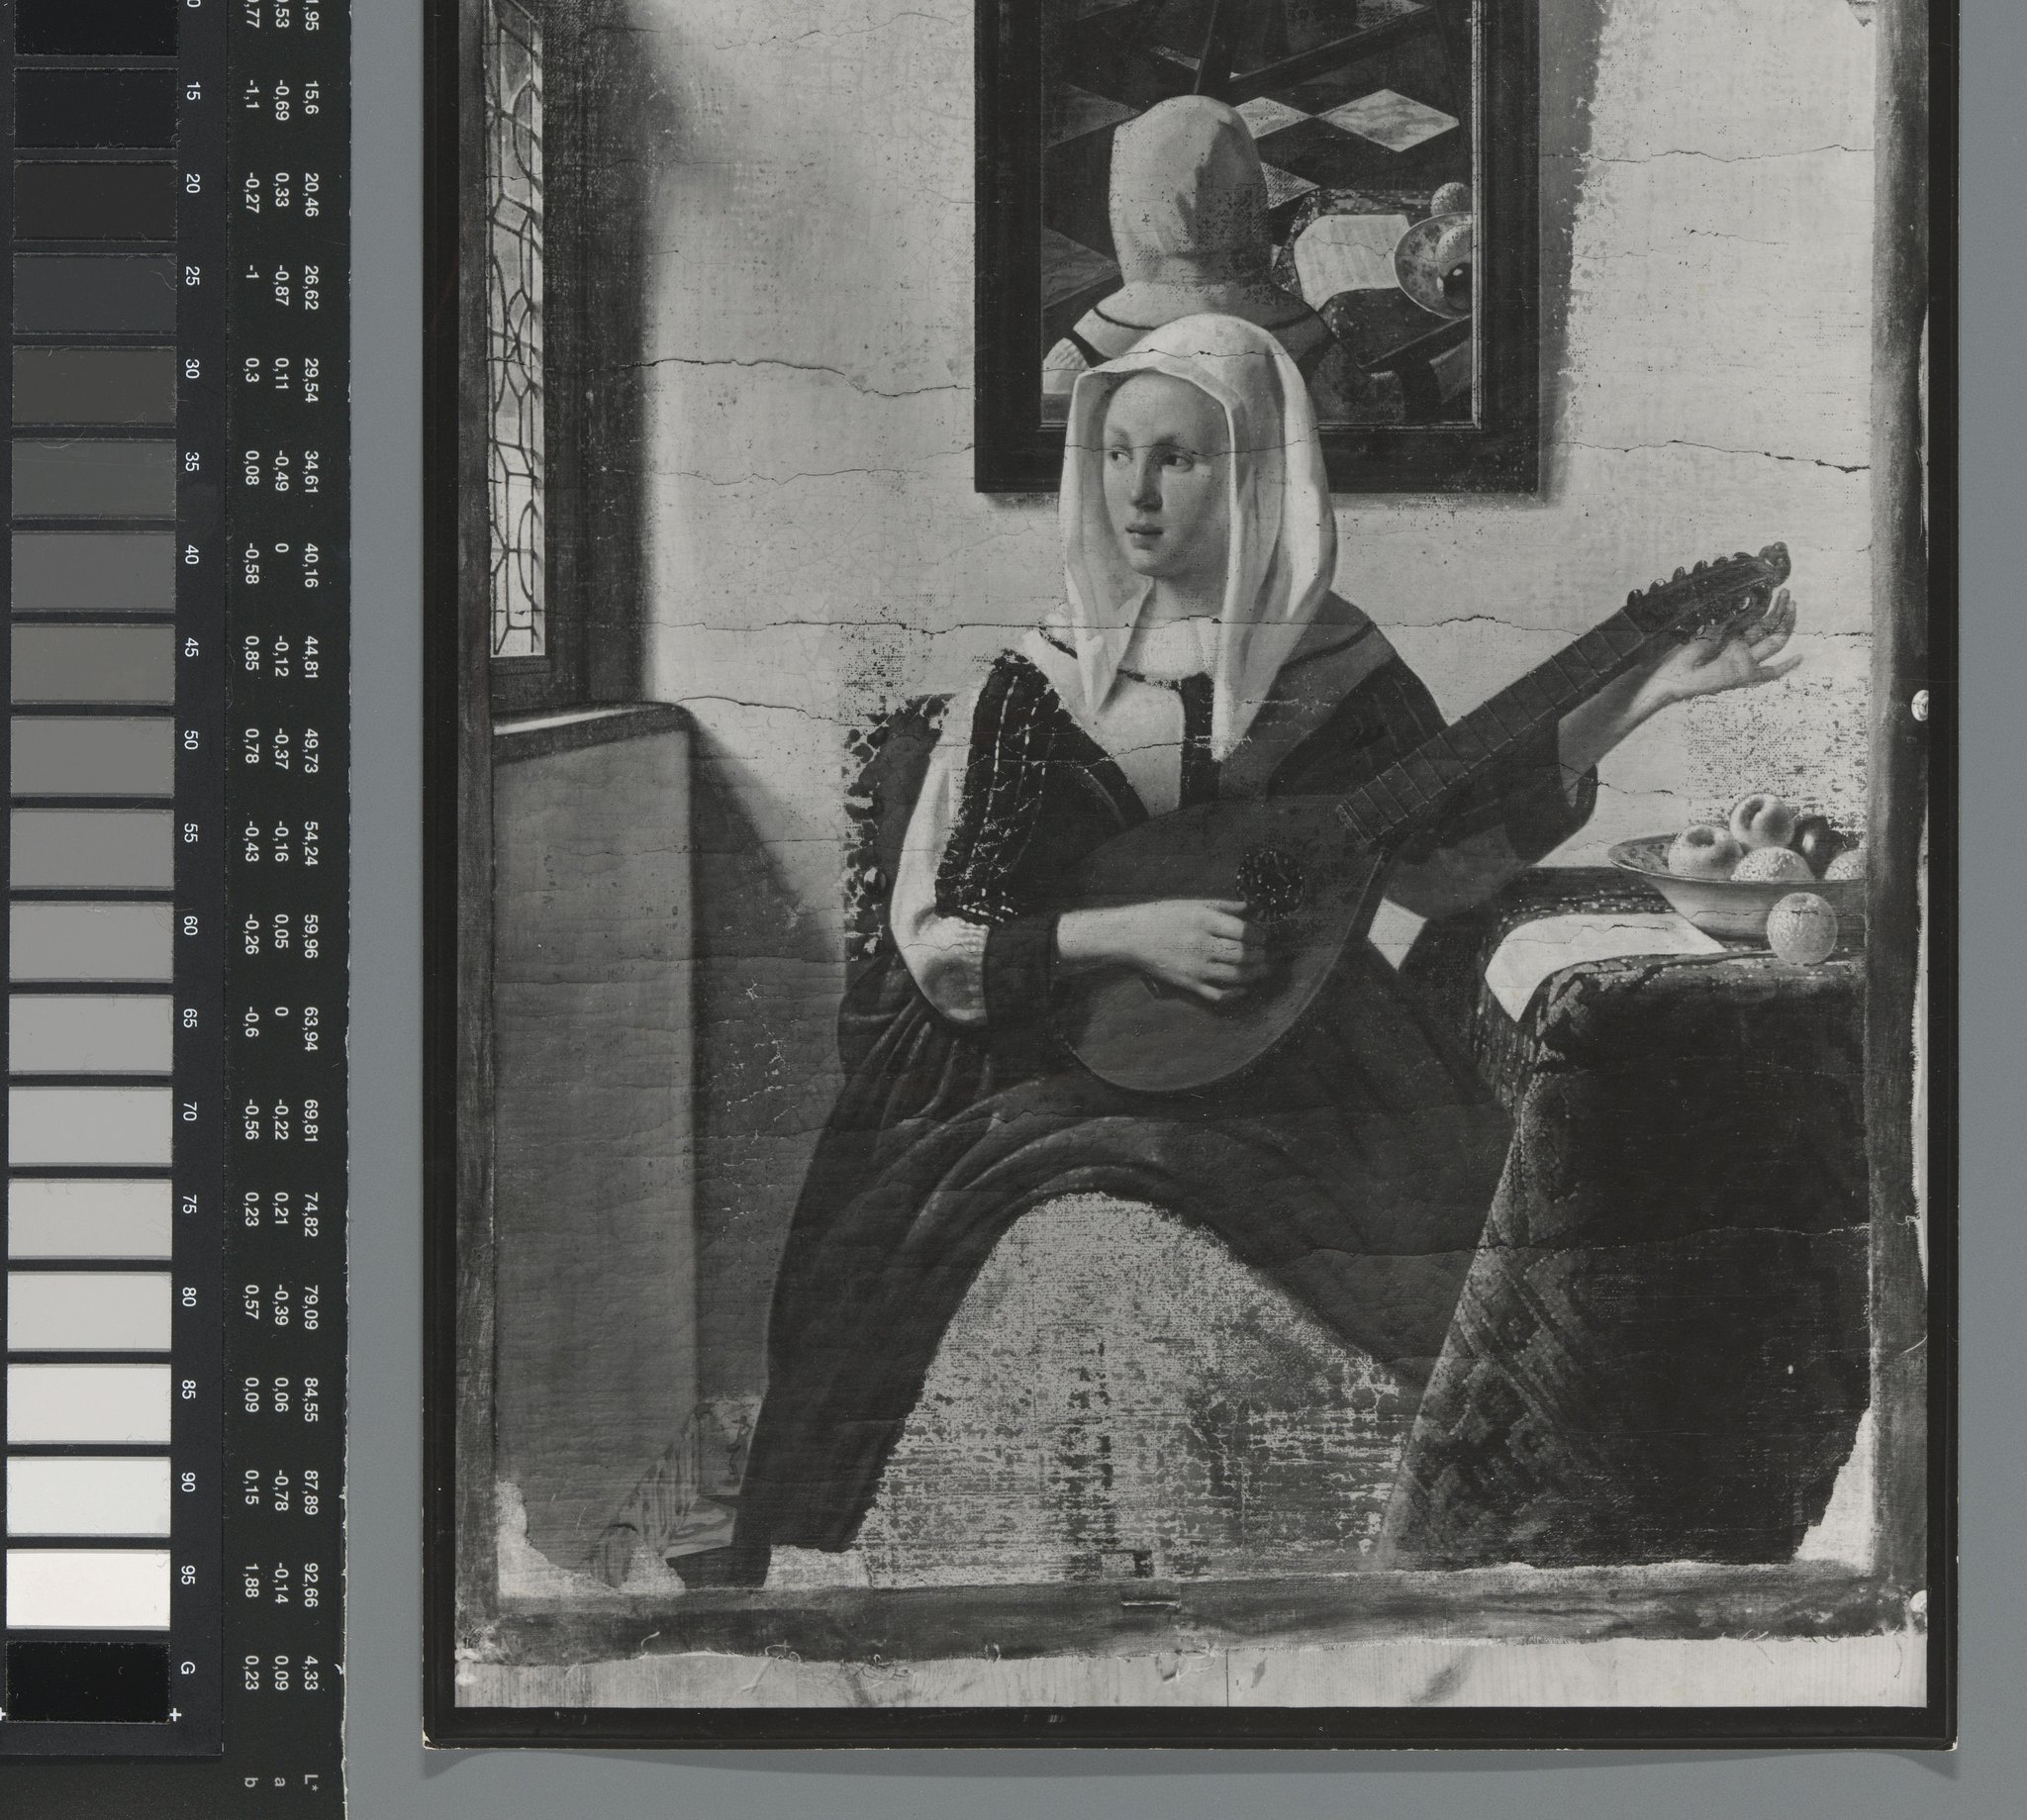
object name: photograph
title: Fotografische reproductie van een (detail) schilderij van Han van Meegeren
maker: nico zomer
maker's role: fotograaf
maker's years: 1910-1988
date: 1908-1948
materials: photographic support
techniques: gelatin silver print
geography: amsterdam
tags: picture, painting